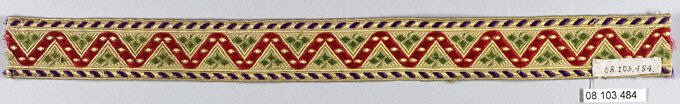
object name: galloon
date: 1801-1900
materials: silk